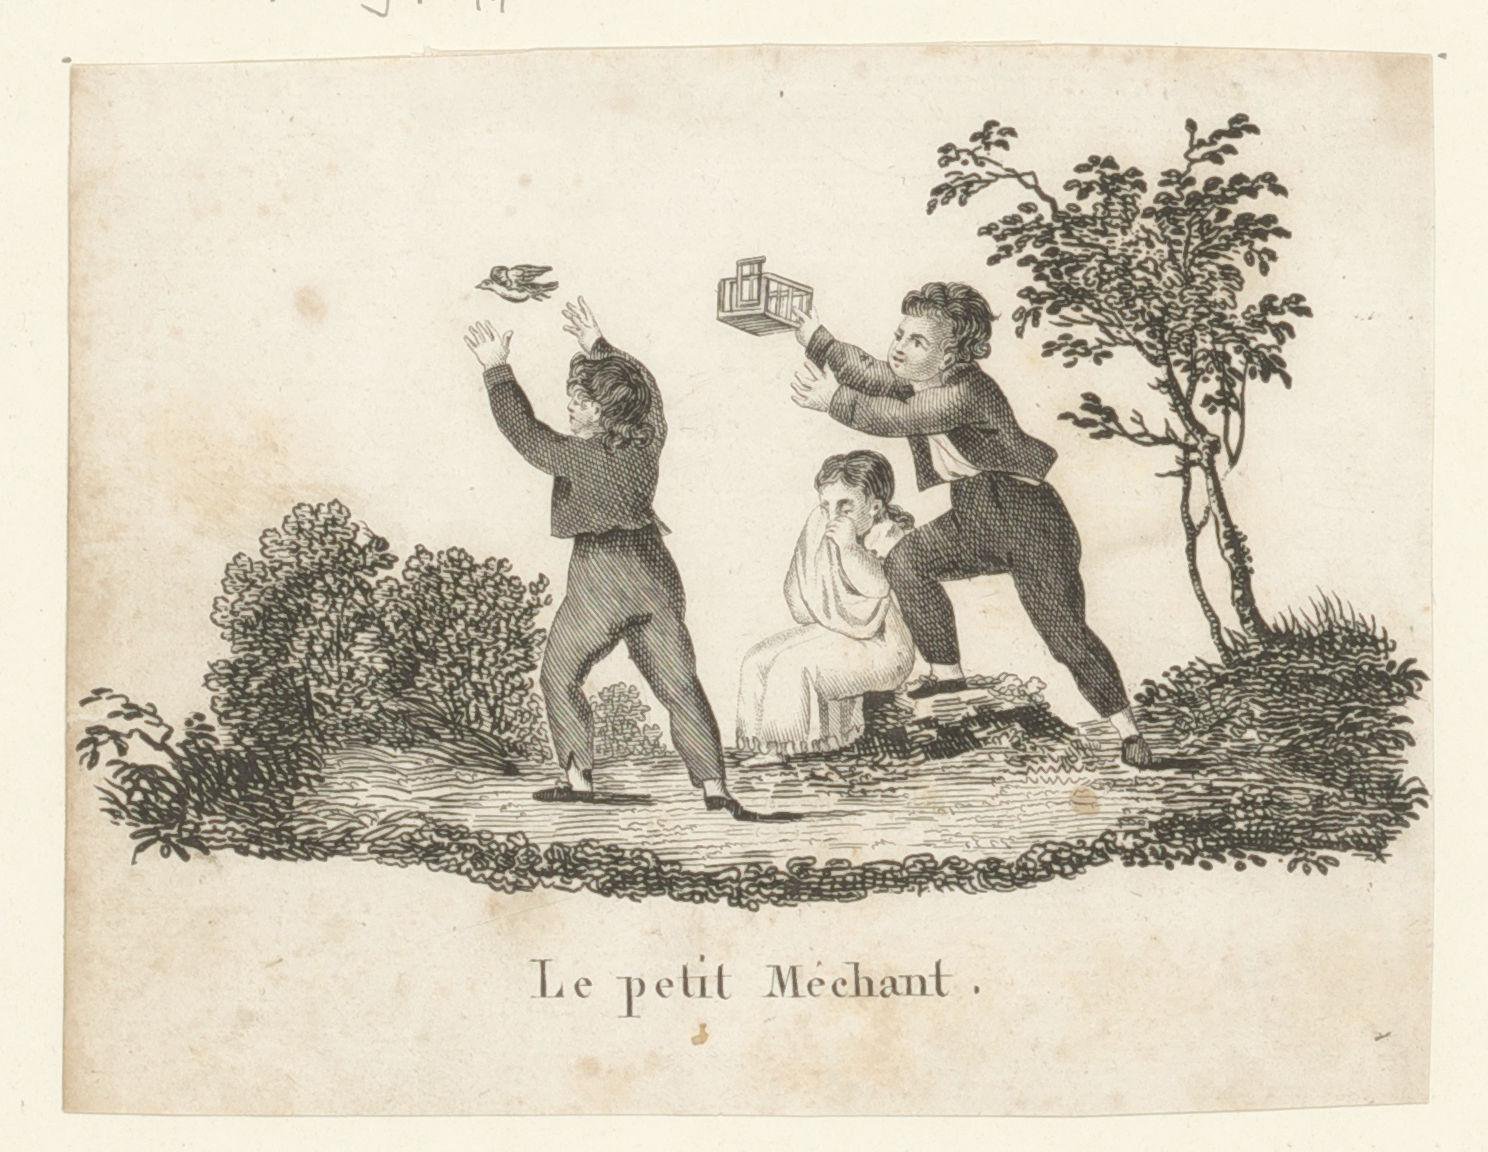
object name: print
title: Drie kinderen spelen met een vogeltje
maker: Anonymous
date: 1800-1899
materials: paper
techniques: etching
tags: children's games and plays, bird in a cage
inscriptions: collector's mark: Lugt 1641, stamp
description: Onderwerpsrubrieken binnen de Atlas Zeden en Gewoonten: Zeden en Gewoonten in Engeren Zin, Des menschen beging, midden en einde, Kinderleven – Kinderspel en Kinderprenten.